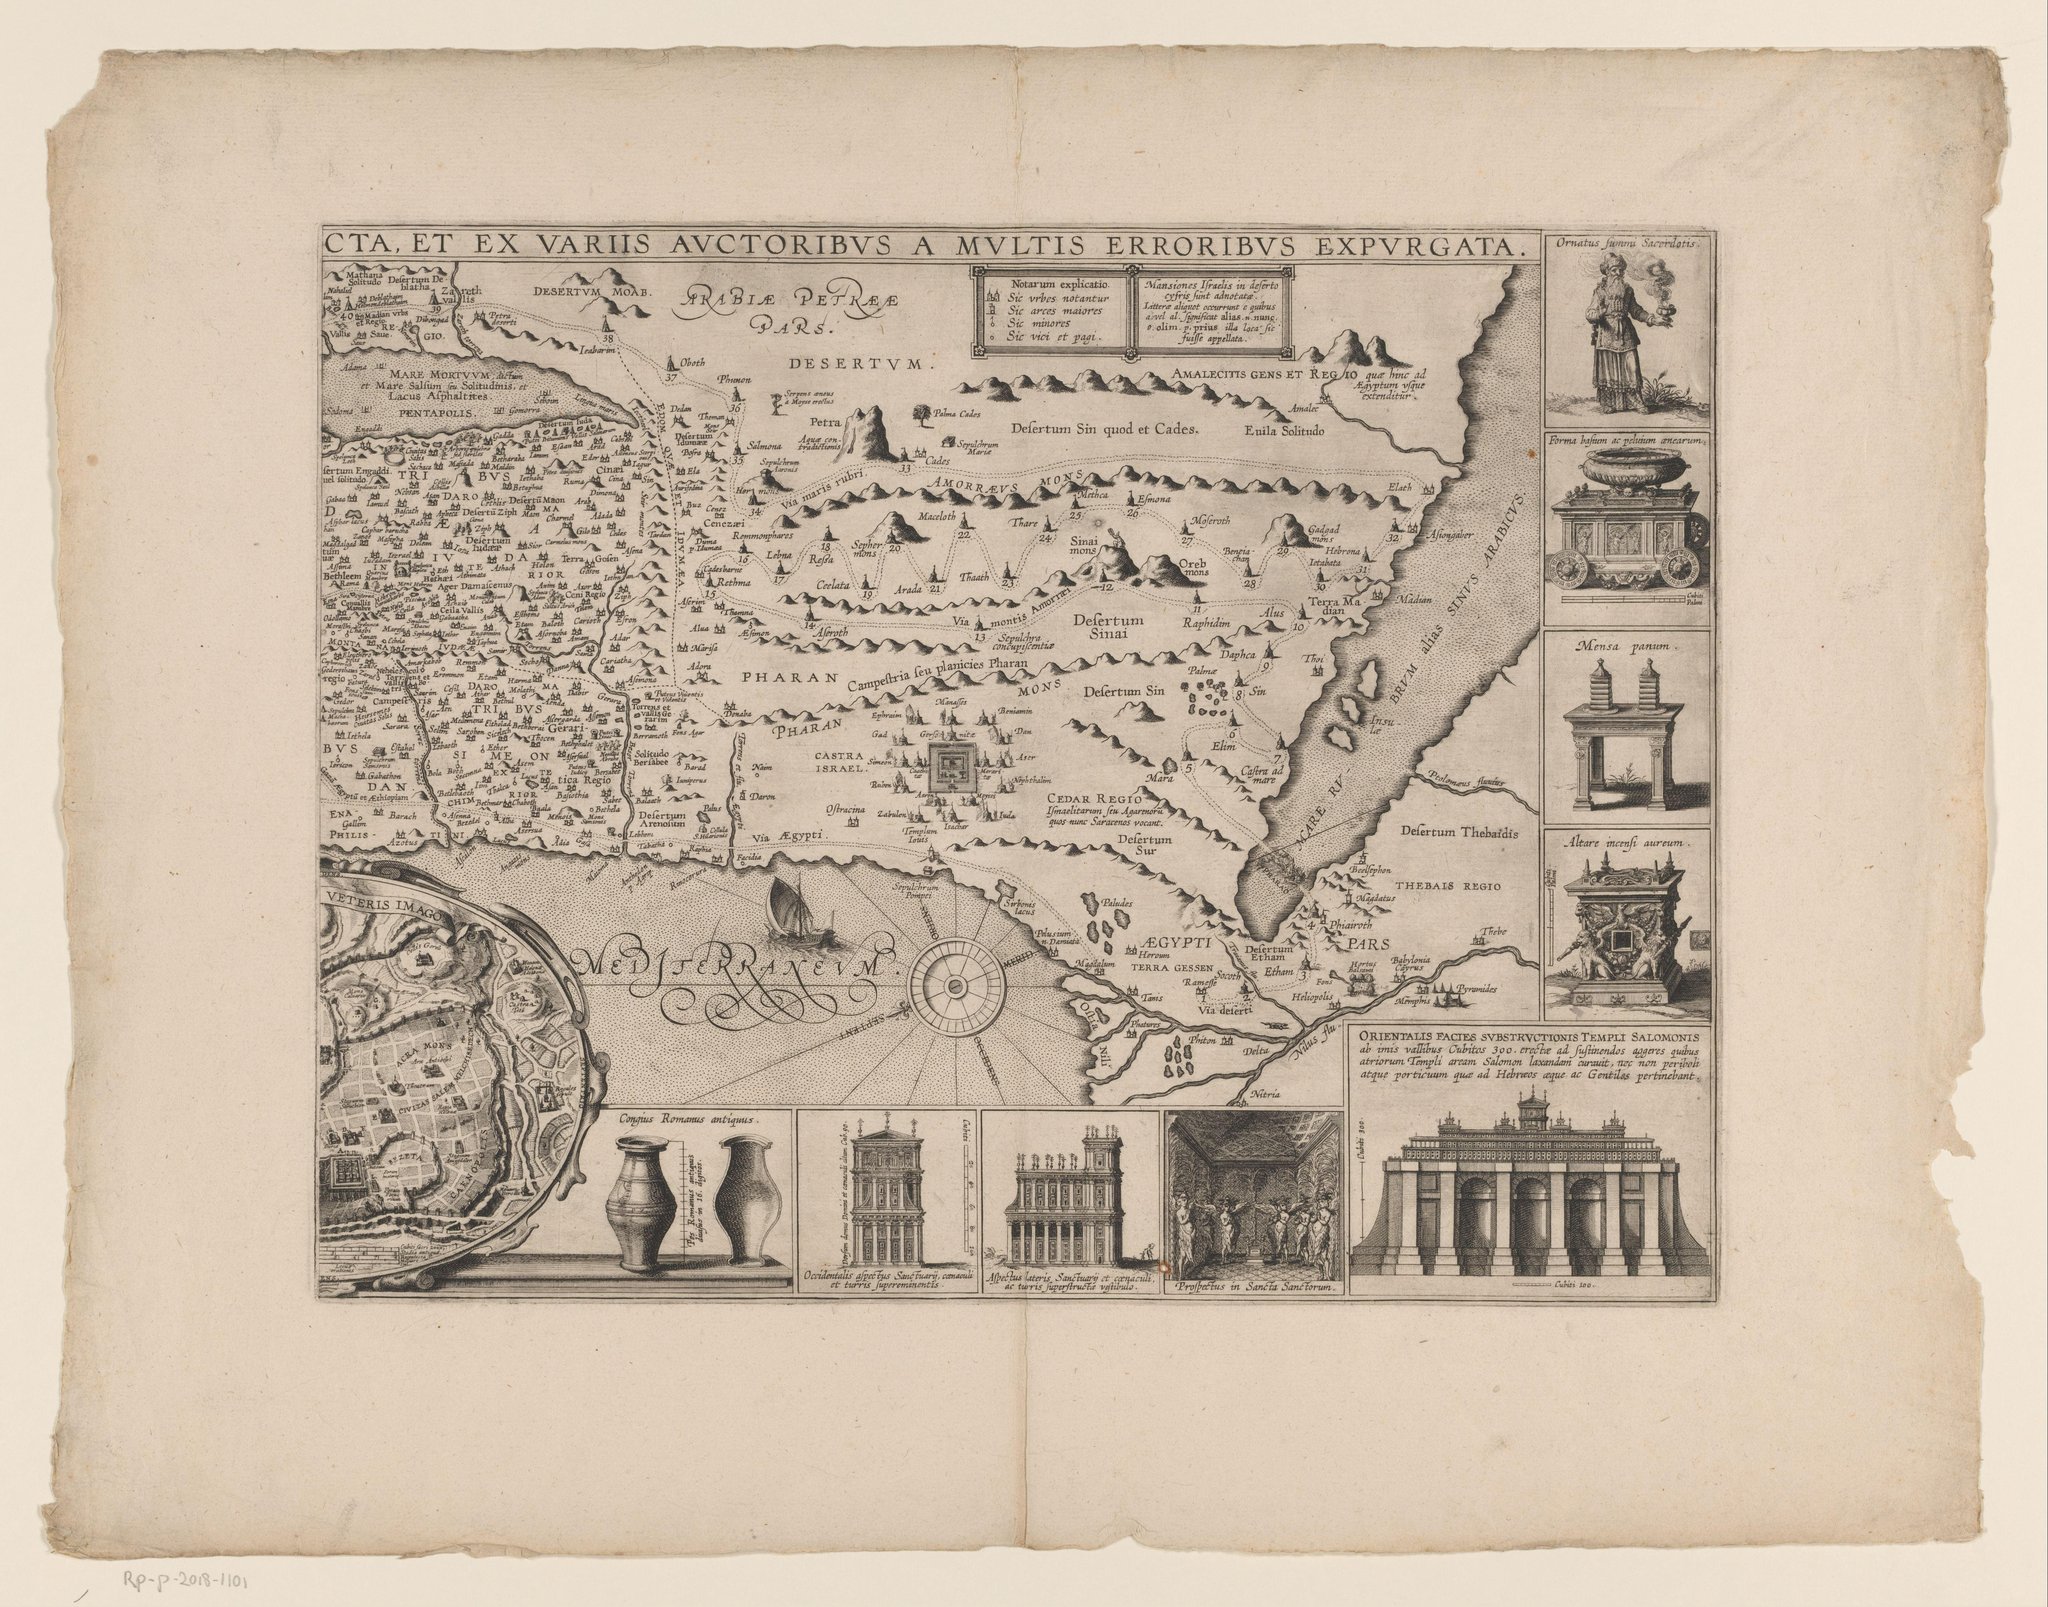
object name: area plan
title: Chorographia Terrae Sanctae in angustiorem formam redacta, et ex variis auctoribus (...)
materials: paper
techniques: engraving, etching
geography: antwerp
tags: maps of separate countries or regions, the book exodus: story of moses and aaron, maps of cities, the temple (in general) ~ jewish religion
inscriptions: collector's mark: Lugt 2228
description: Prent ook gebruikt in: Tirinus, Jacobus. Commentarius in Vetus et Novum Testamentum. Antwerpen: Martiuns Nutius (III), 1632.